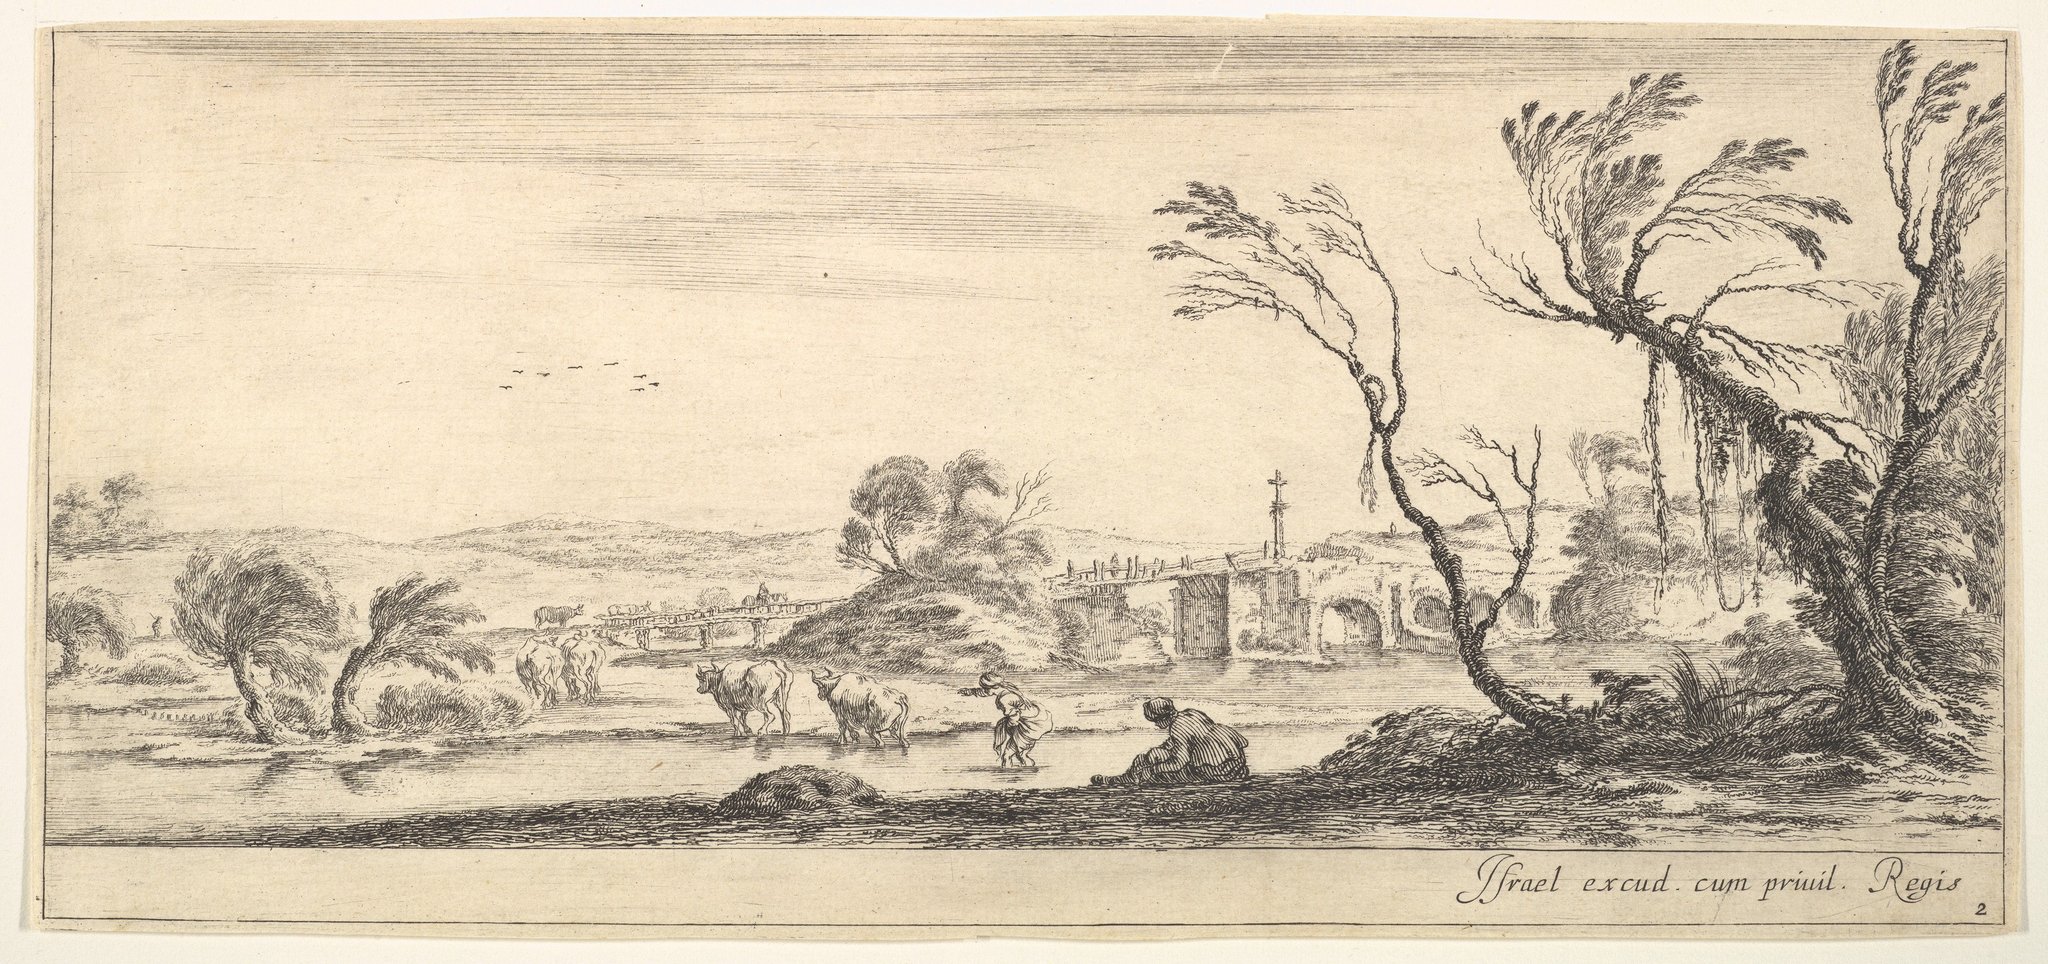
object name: print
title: Plate 2: a peasant woman removing her shoes in center, another peasant woman and two cows in a stream to left, a bridge to right in the background, from "Various Landscapes" (Divers Paysages)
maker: stefano della bella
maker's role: artist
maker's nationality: italian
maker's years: 1610-1664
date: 1641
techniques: etching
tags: women,cows,landscapes